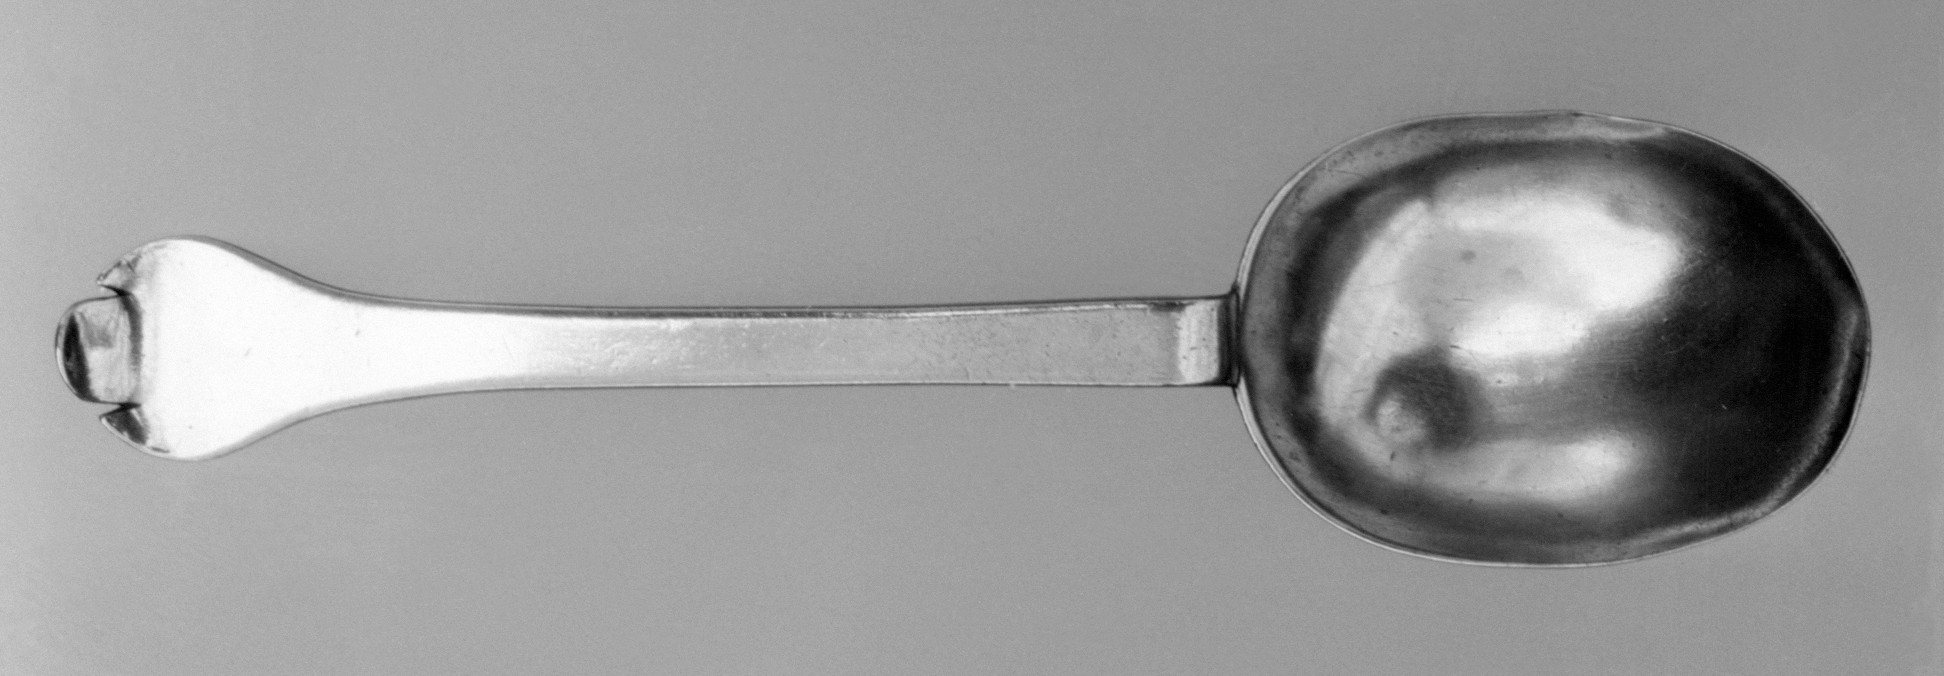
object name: spoon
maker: john smith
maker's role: maker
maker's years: 1641-1690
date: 1663-1664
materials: silver